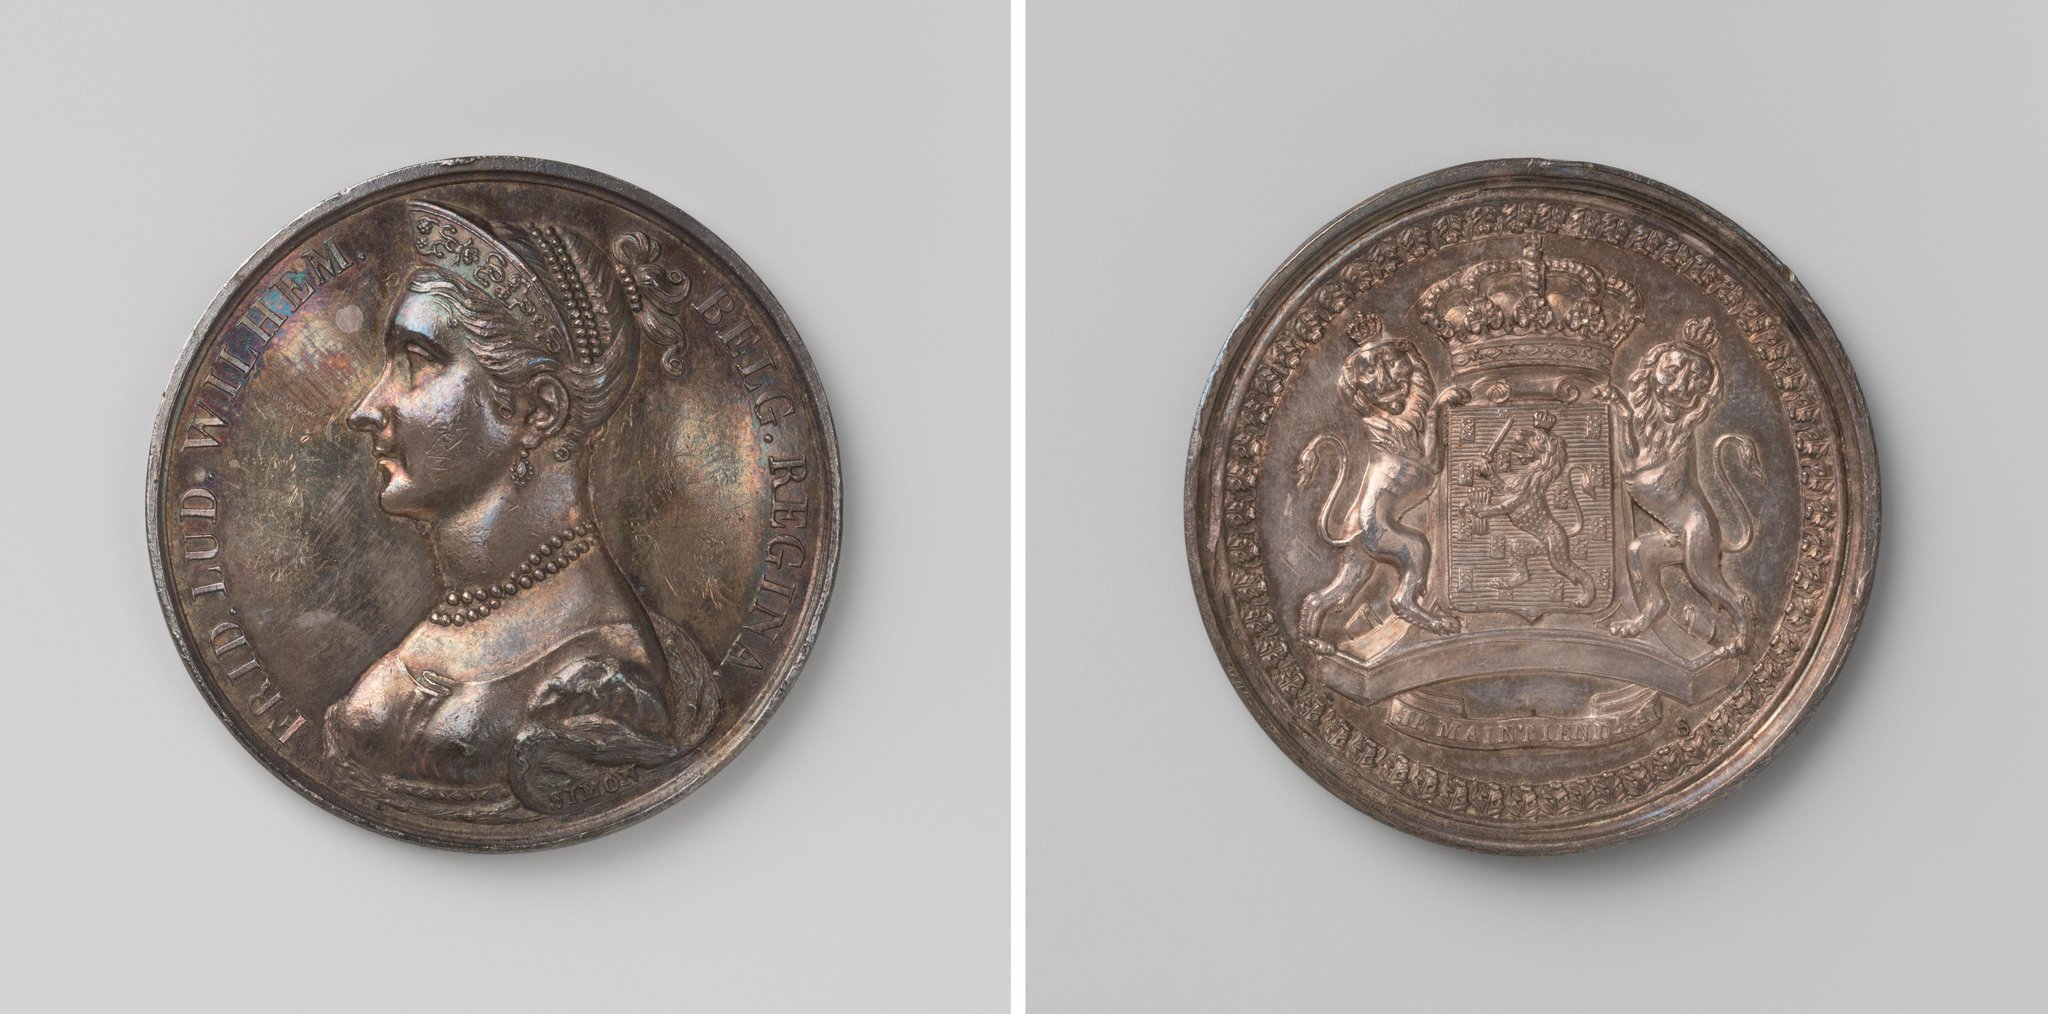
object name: honorary medal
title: Frederika Louise Wilhelmina, prinses van Oranje-Nassau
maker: jean henri simon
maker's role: medailleur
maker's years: 1752-1834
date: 1820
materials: silver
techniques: striking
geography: brussels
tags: the hague, amsterdam, louise (prinses van oranje-nassau)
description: Zilveren penning. Voorzijde: borststuk vrouw binnen omschrift. Keerzijde: gekroond wapenschild, geflankeerd door twee gekroonde leeuwen boven wimpel met opschrift binnen sierrand